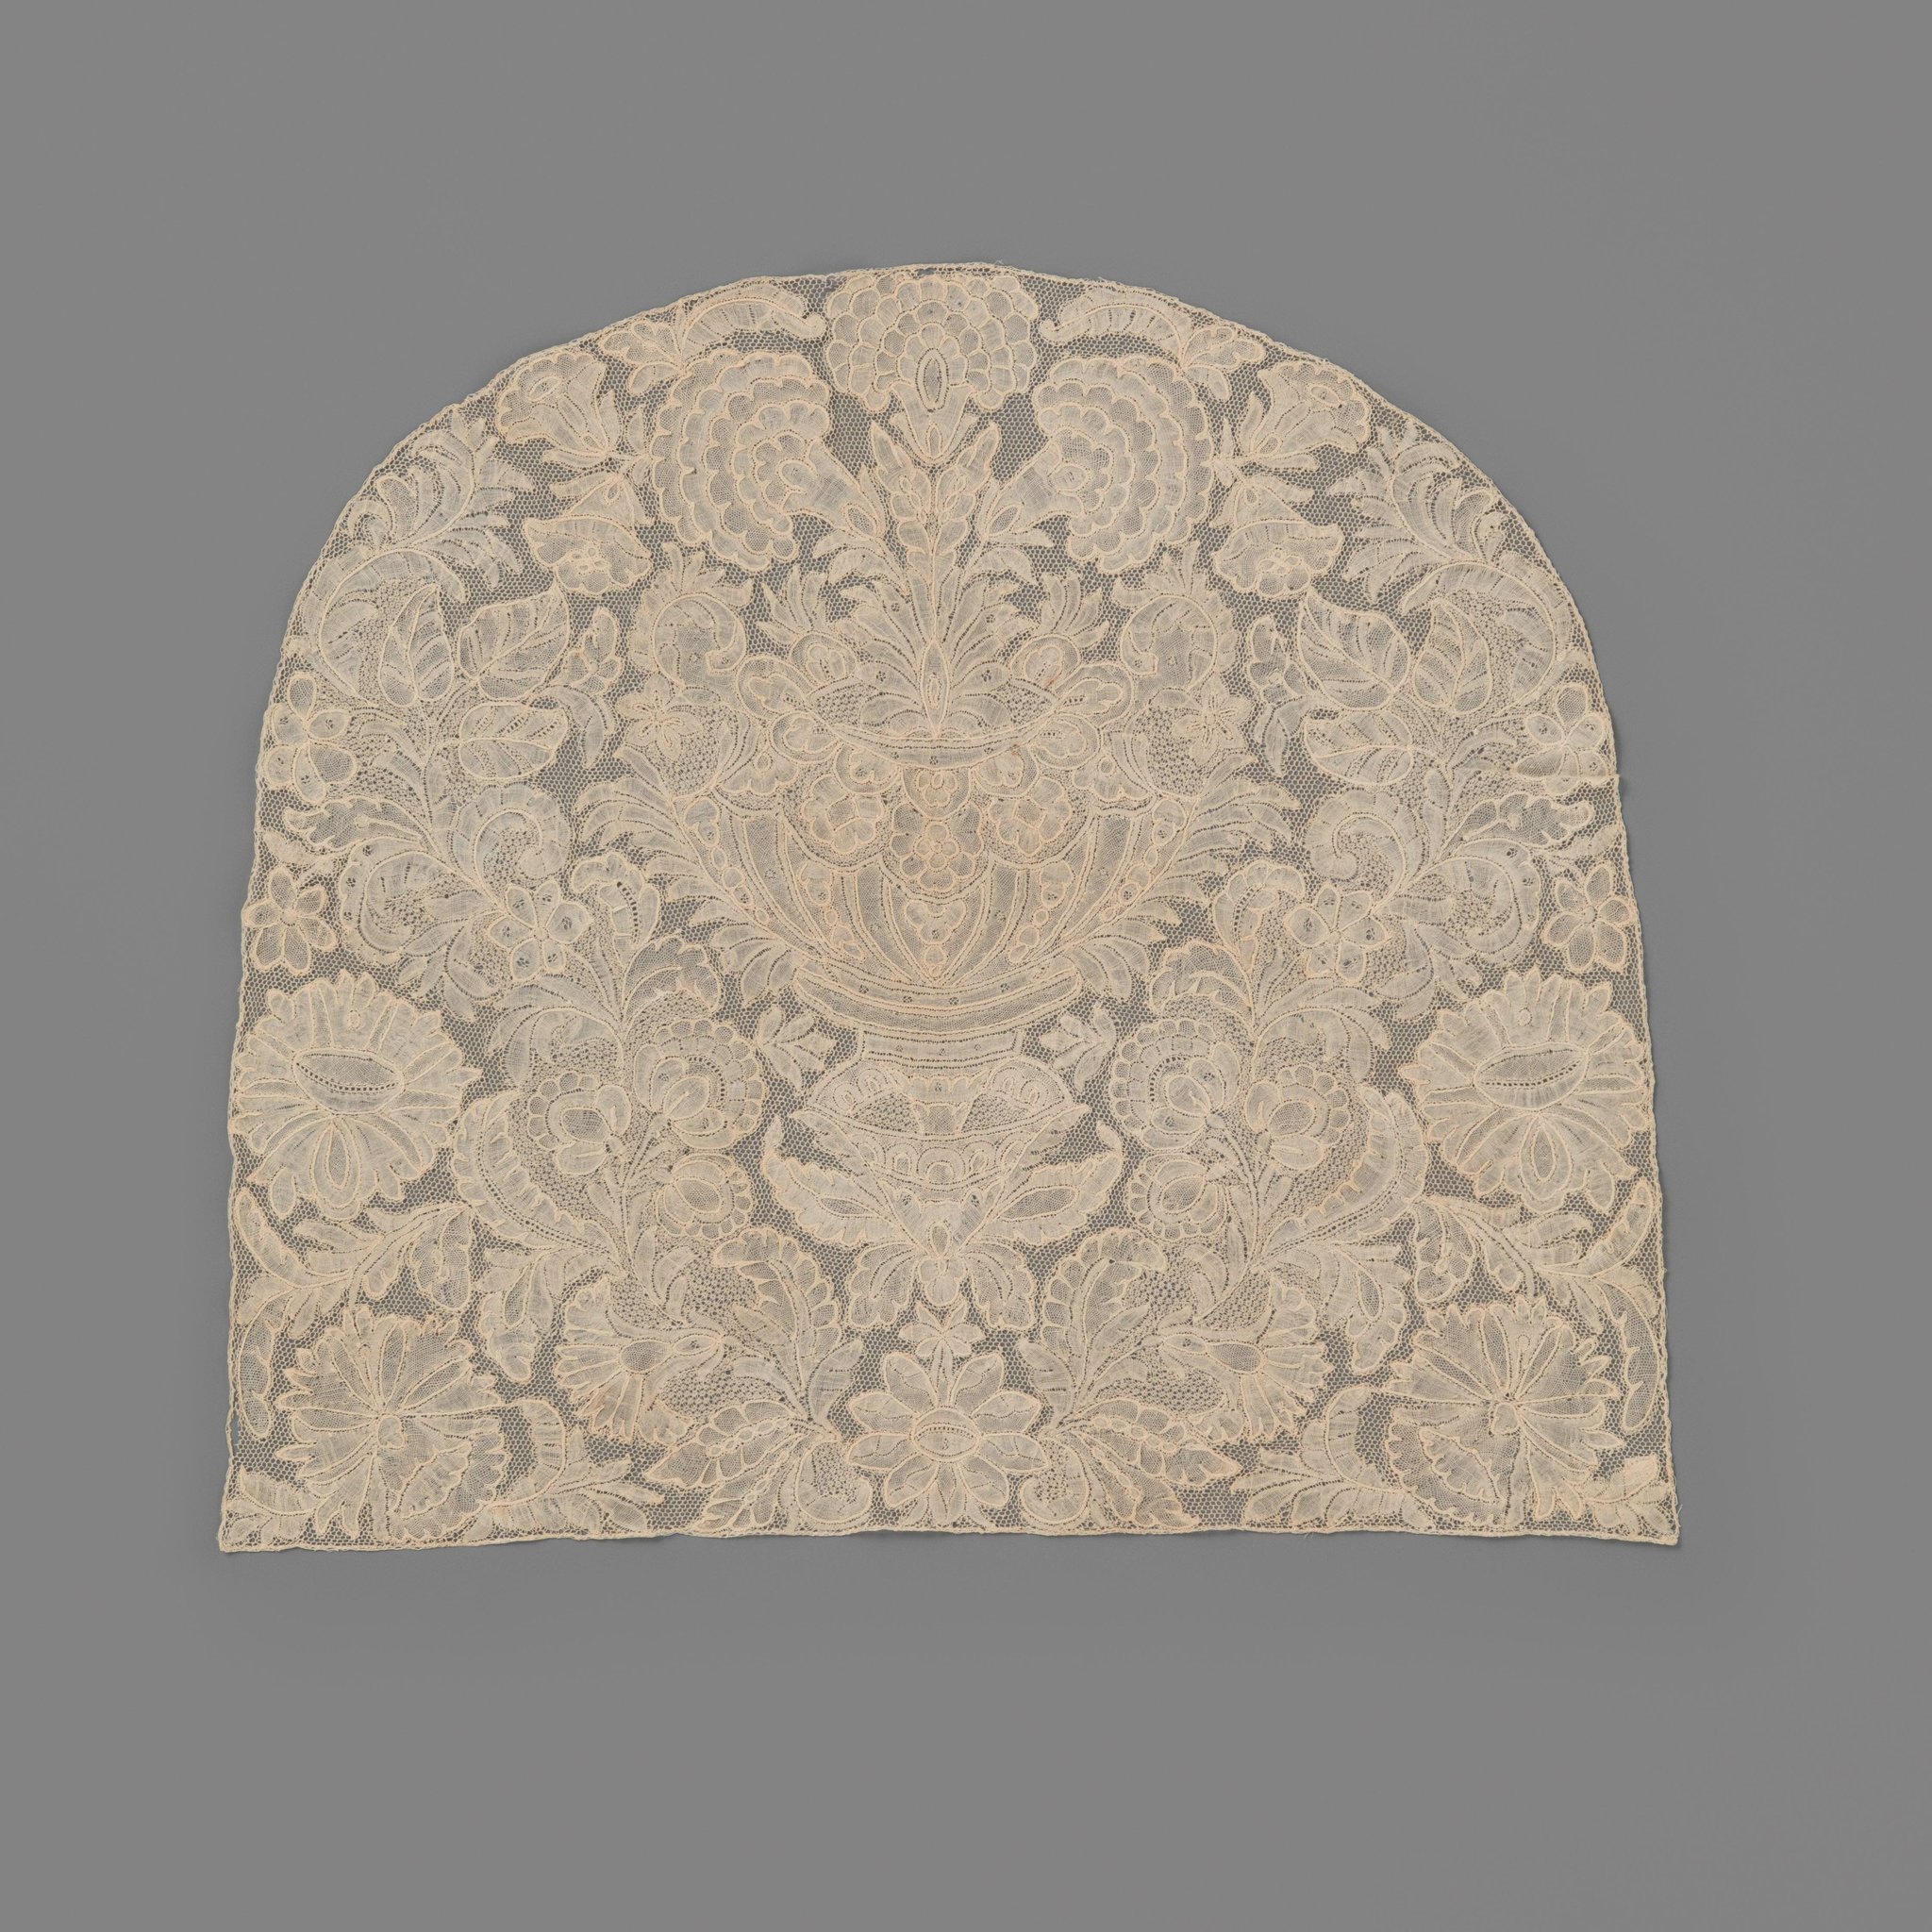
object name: womenswear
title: Mutsenbol van Vieux Bruxelles kloskant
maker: Anonymous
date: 1715-1725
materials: lace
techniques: lace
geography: brussels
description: Mutsenbol in Vieux Bruxelles, "met de tuinvasen". Techniek: een fond Driekel in overheerst door het ornament, Zeer fijne linnen-en netslag. Sporadische portes. Overal een brodé langs de omtrek. Enkele siersteken als huis-in-huis vulling, zoals spinnen en blaadjesteek. Patroon: laatse voorkomen van symmetrie. Mutsenbol: een grote tuinvaas met gelobde bak staat op dunne stam, die uit een bekerbloem oprijst. In de bak ontspruit uit een taxza een grote driedubbele tak met drie anjers. Links en rechts hiervan groeien twee schuingerichte bloemtakken met gevederde bladeren. Barbes: de vorm is taps toelopend naar de rechte benedenhoeken. De shculpen zijn zeer flauw. Boven elkaar staan twee tuinvazen: de bovenste iets gevariëerd van die van de bol, de benedenste heeft een bekervormige bak op gewelfde voet. Er is een onderstuk gevat in drie bladeren, en een bovendeel met raster, werk en een overkragende rand.